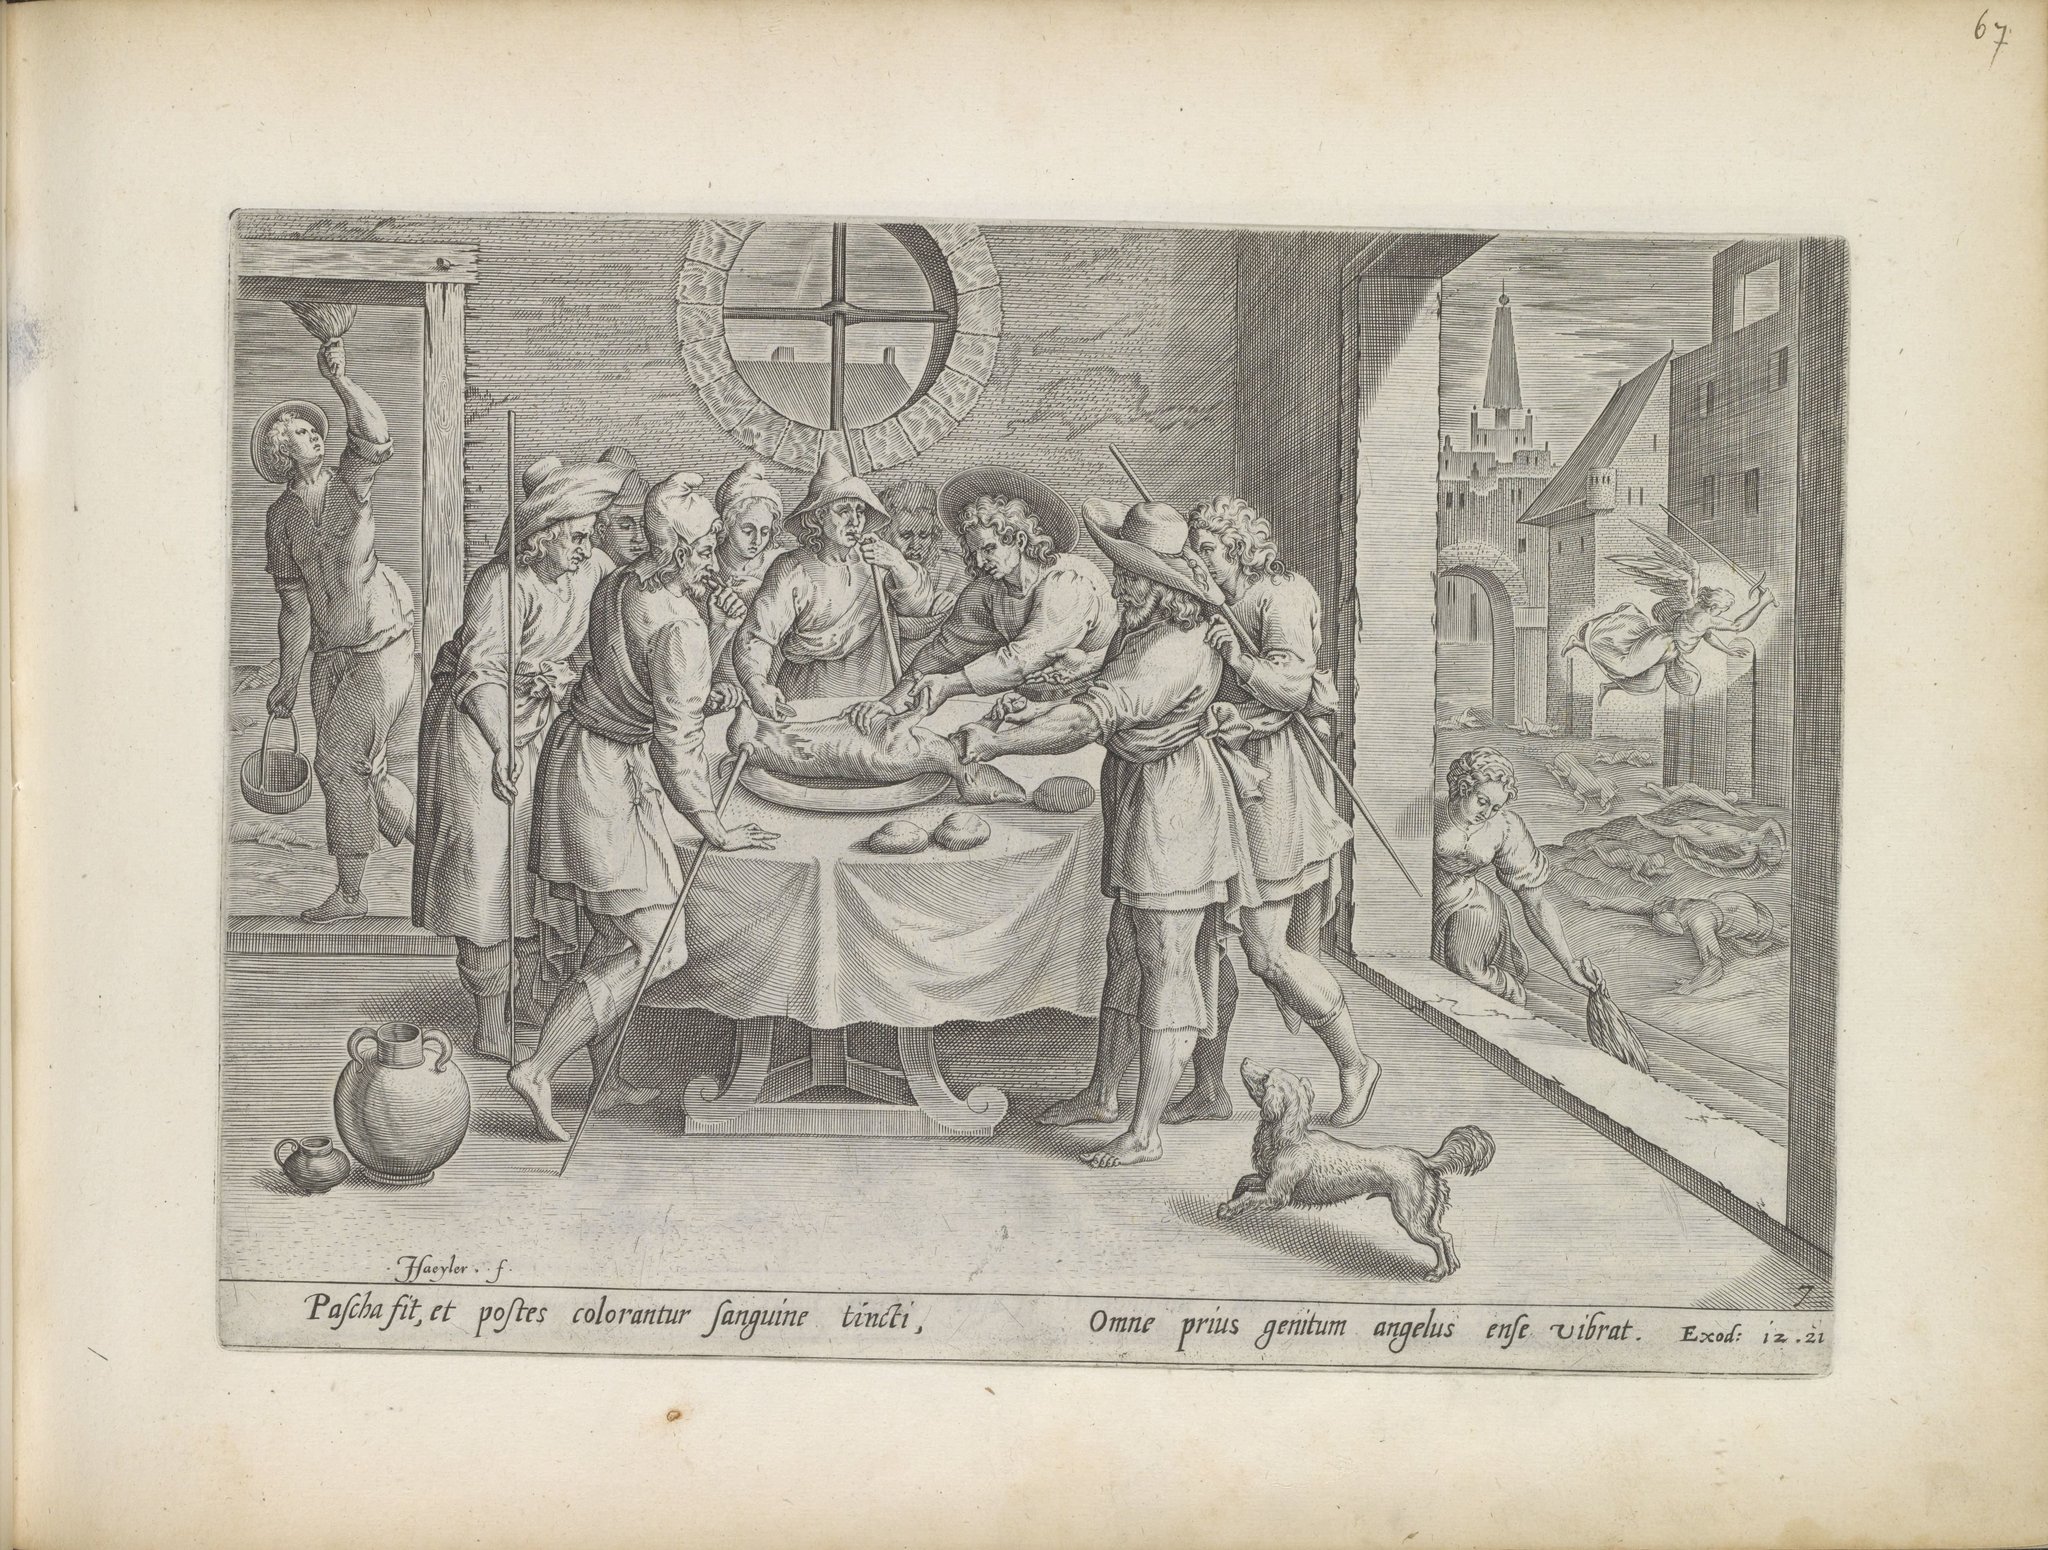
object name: album leaf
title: Pesachfeest en de tiende plaag van Egypte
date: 1579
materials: paper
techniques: engraving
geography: amsterdam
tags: with lamb's blood the israelites make marks (usually tau-crosses) on the doorposts of their houses, the israelites eat the passover lamb standing about a table with their loins girt, their shoes on their feet and with staves in their hands, ready to depart, the plague of the first-born: the destroying angel passes through the land and kills every egyptian first-born of man and animal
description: Op de voorgrond een Joodse familie rond een tafel met het pesachoffer: een geslacht lam. De deuren van Joodse huizen worden met lamsbloed gemarkeerd. Rechts de tiende plaag van Egypte: een doodsengel doodt alle eerstgeborenen van Egypte, maar gaat voorbij aan de huizen met bloed aan de deurposten. Onder de voorstelling een verwijzing in het Latijn naar de Bijbeltekst in Ex. 12:21. Deze prent maakt deel uit van een album.